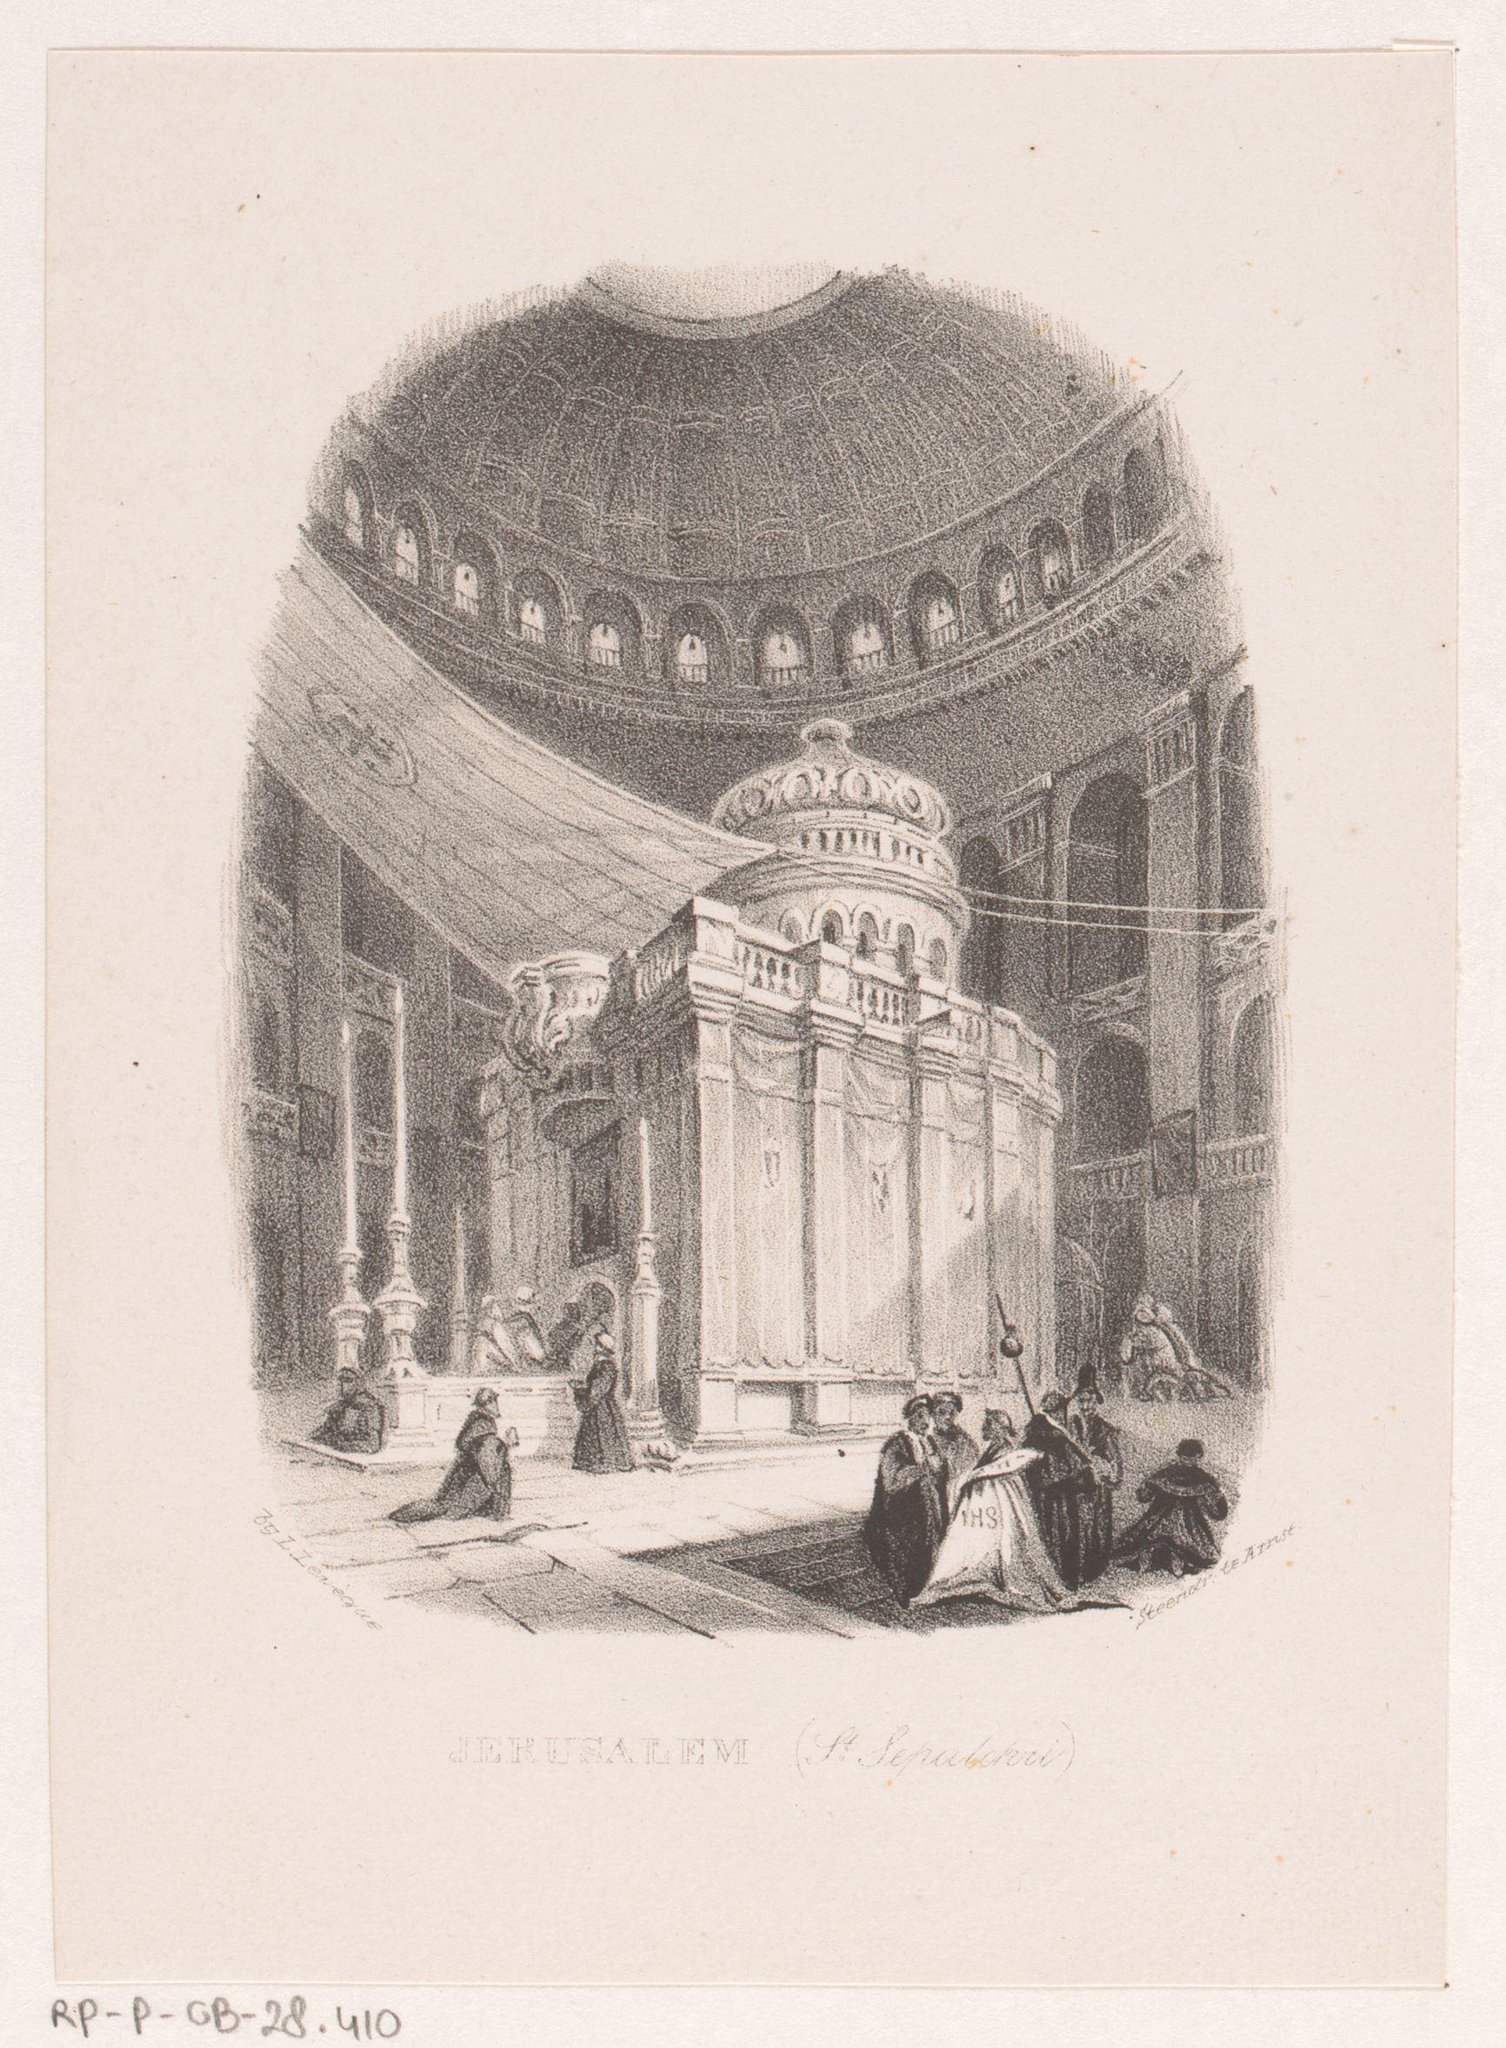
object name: print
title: Jerusalem (St. Sepulchri)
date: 1850-1863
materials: paper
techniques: lithograph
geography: amsterdam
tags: grave, tomb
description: De tombe staat in de Heilig Grafkerk onder de centrale koepel. Er omheen staan figuren.